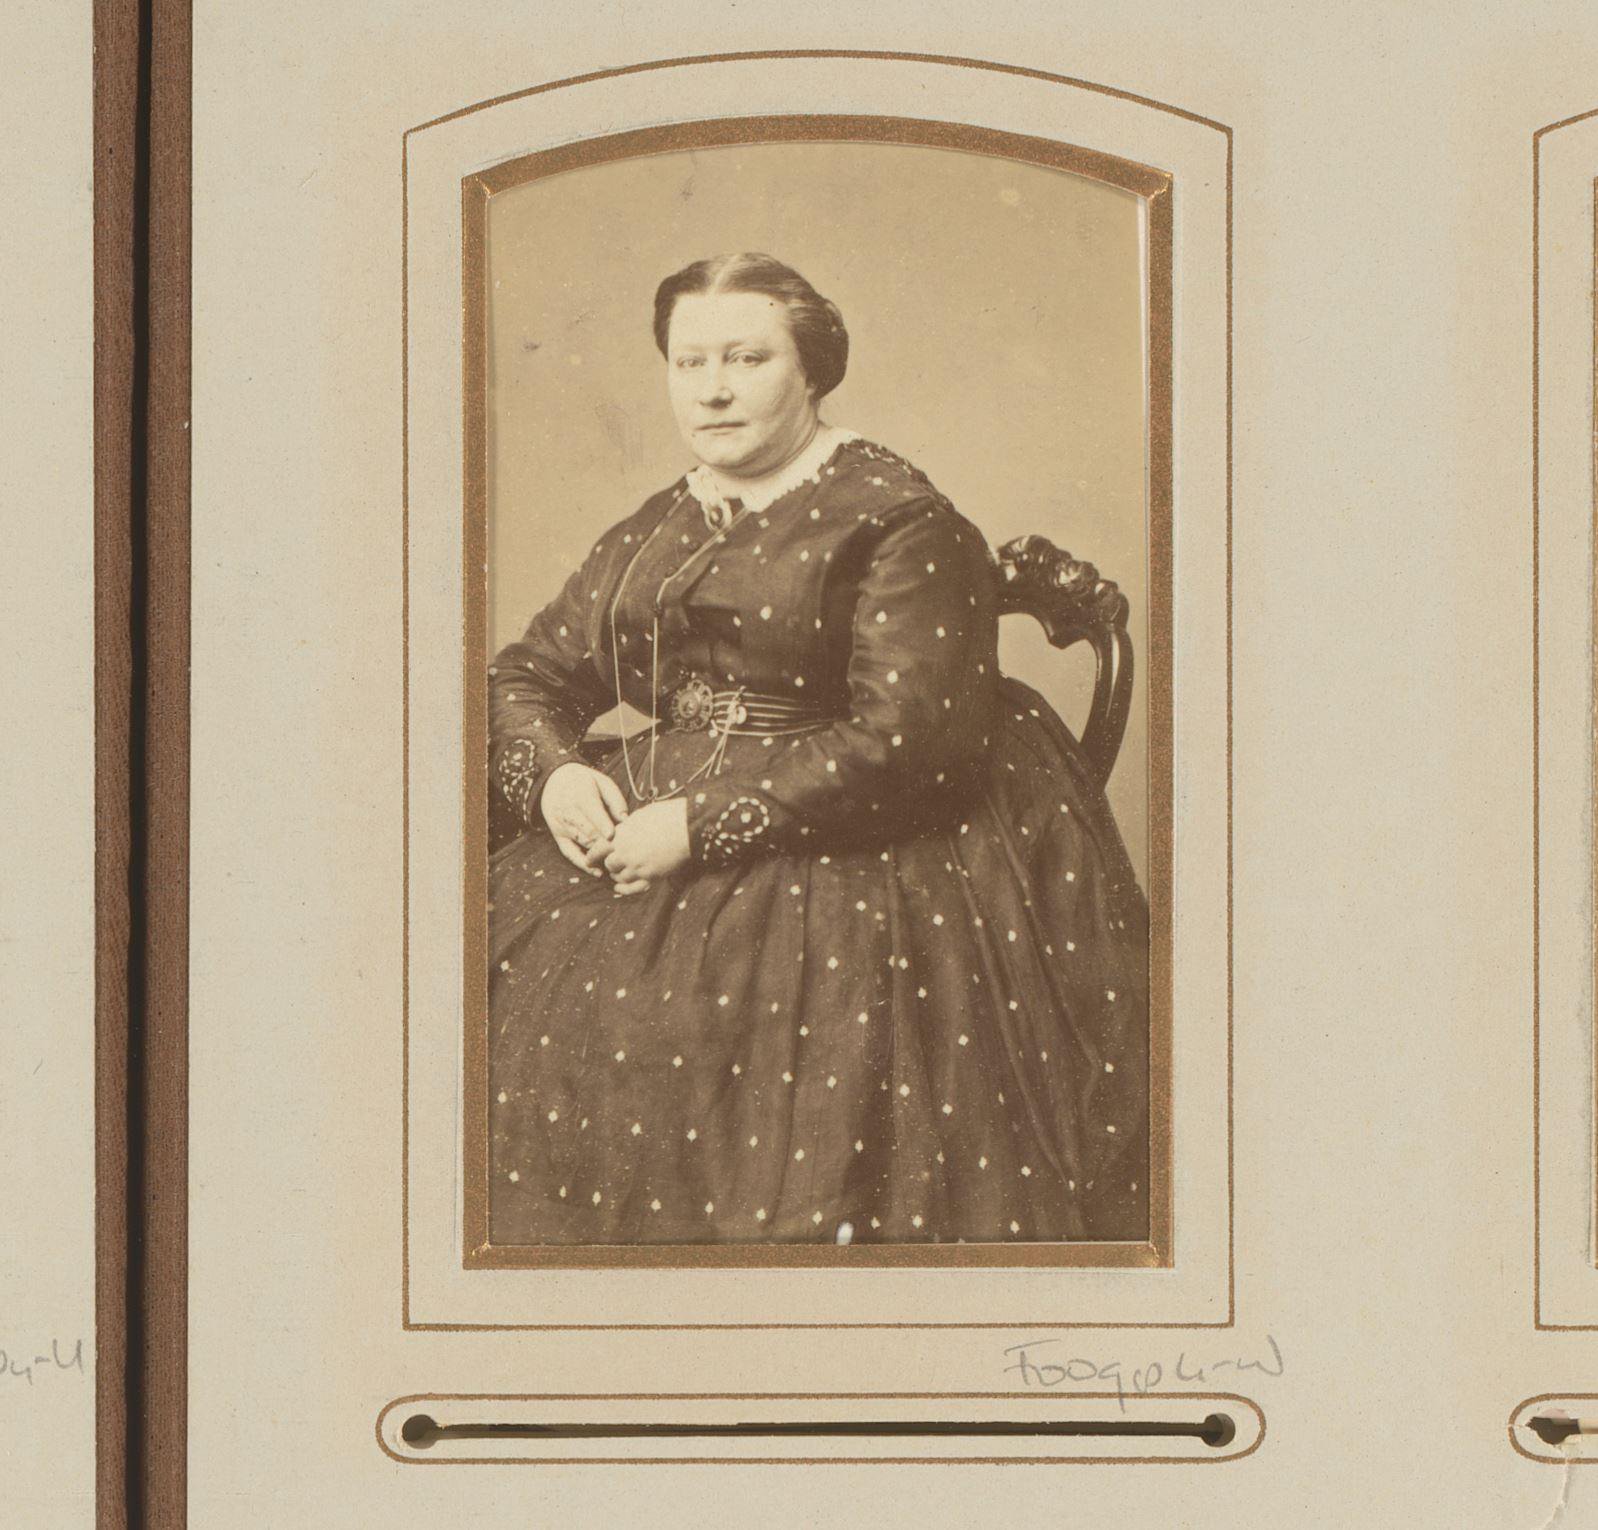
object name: carte de visite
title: Portret van een zittende vrouw in noppenjapon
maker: johannes hinderikus egenberger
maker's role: draughtsman, print maker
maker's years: 1822-1897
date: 1864-1895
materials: cardboard, photographic support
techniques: albumen print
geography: groningen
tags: sitting figure - aa - female human figure, historical persons - bb - woman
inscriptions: inscription: ‘J. H. EGENBERGER,/ GRONINGEN.’